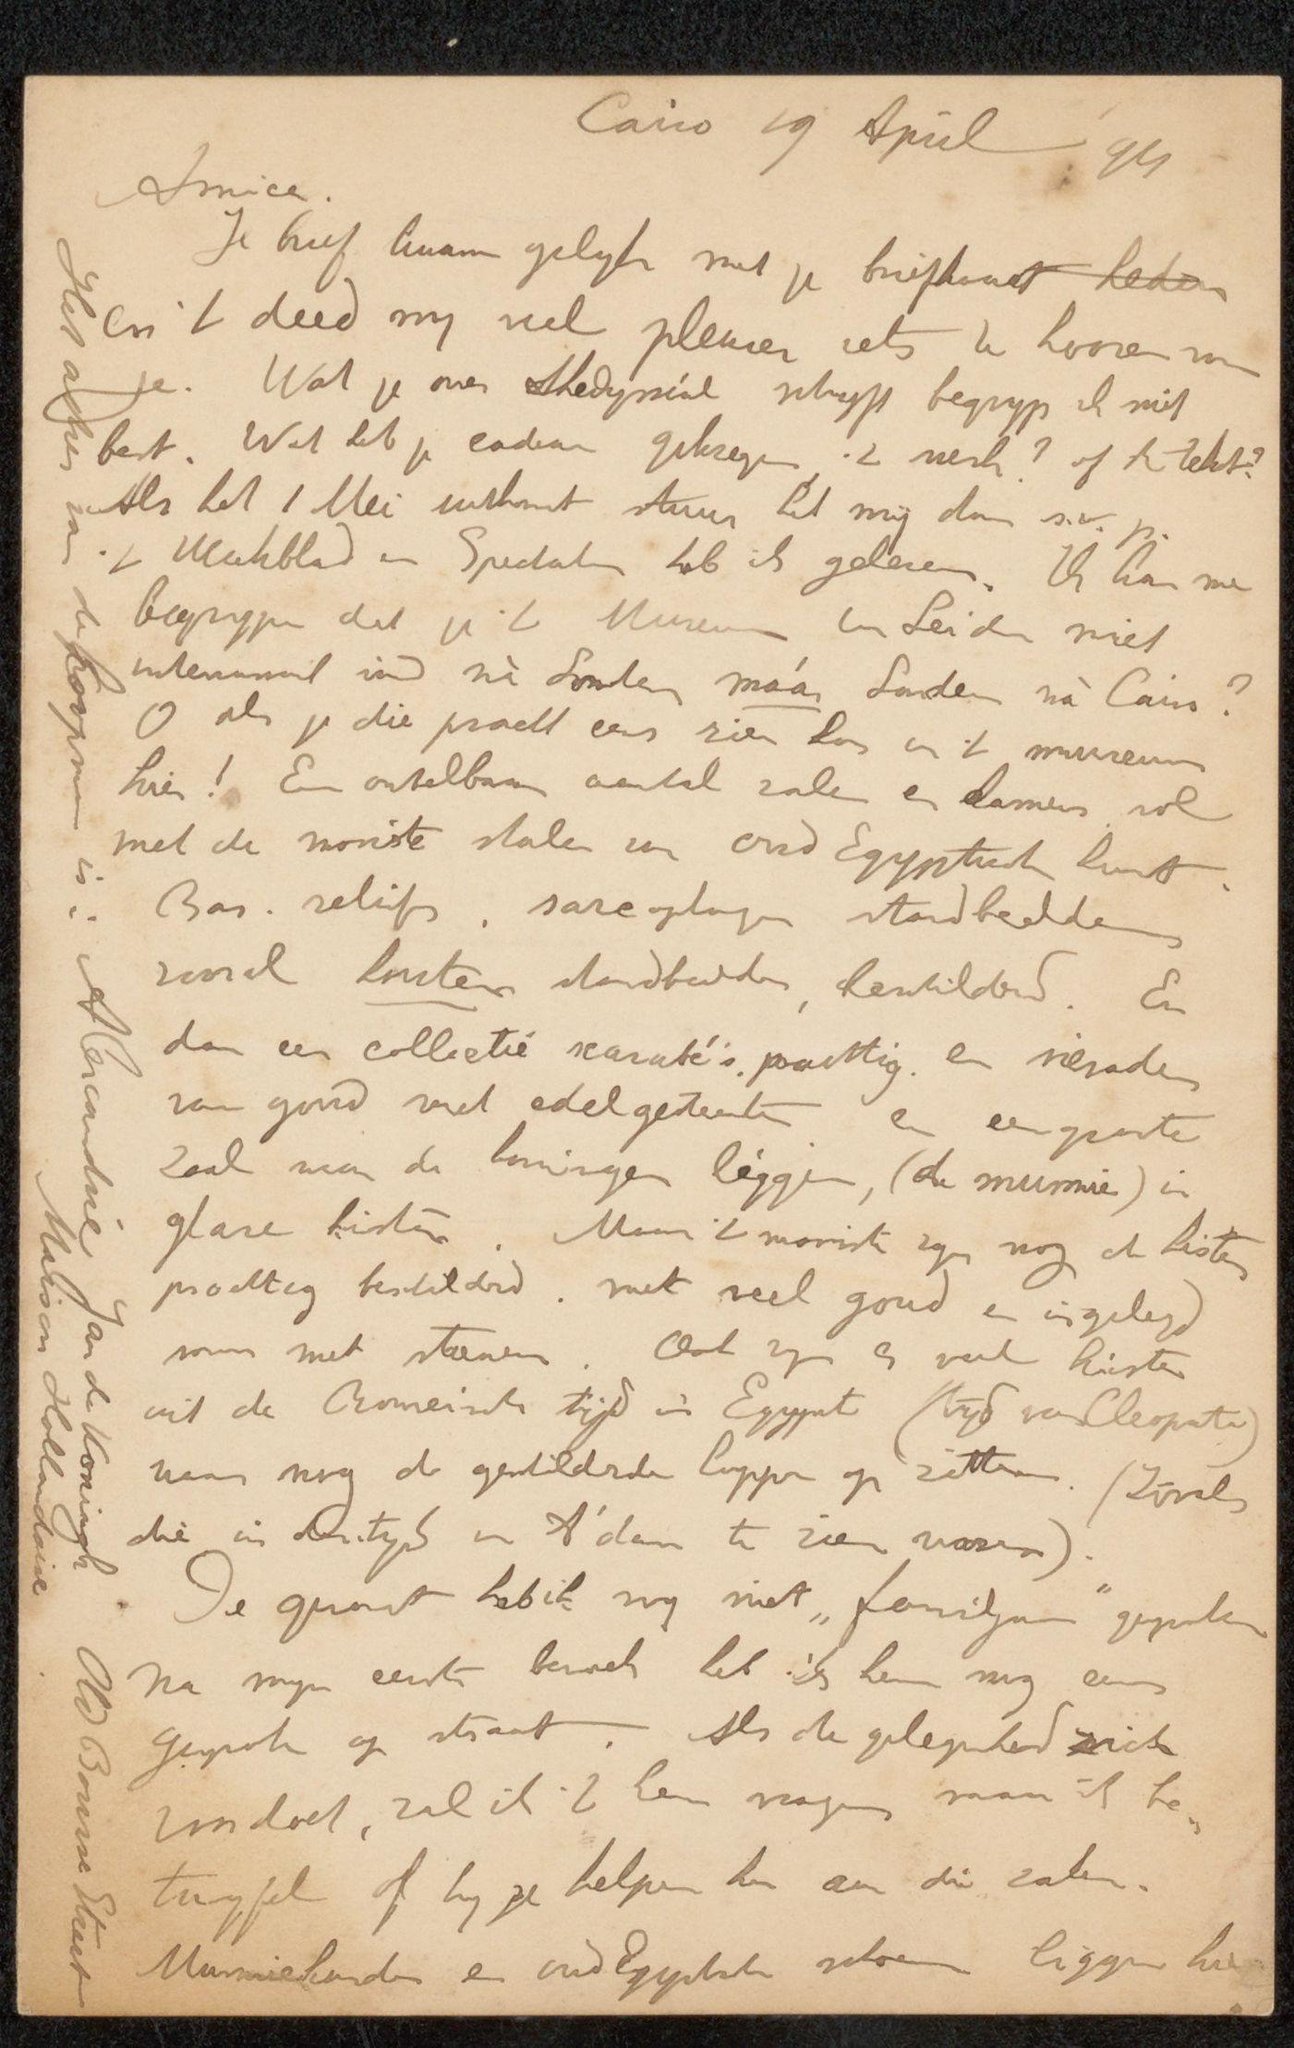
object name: letter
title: Brief aan Philip Zilcken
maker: marius bauer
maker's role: draughtsman, print maker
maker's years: 1867-1932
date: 1894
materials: ink, paper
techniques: pen, writing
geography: cairo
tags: the hague, painter, draughtsman, philip zilcken, river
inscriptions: collector's mark: ‘RPK’